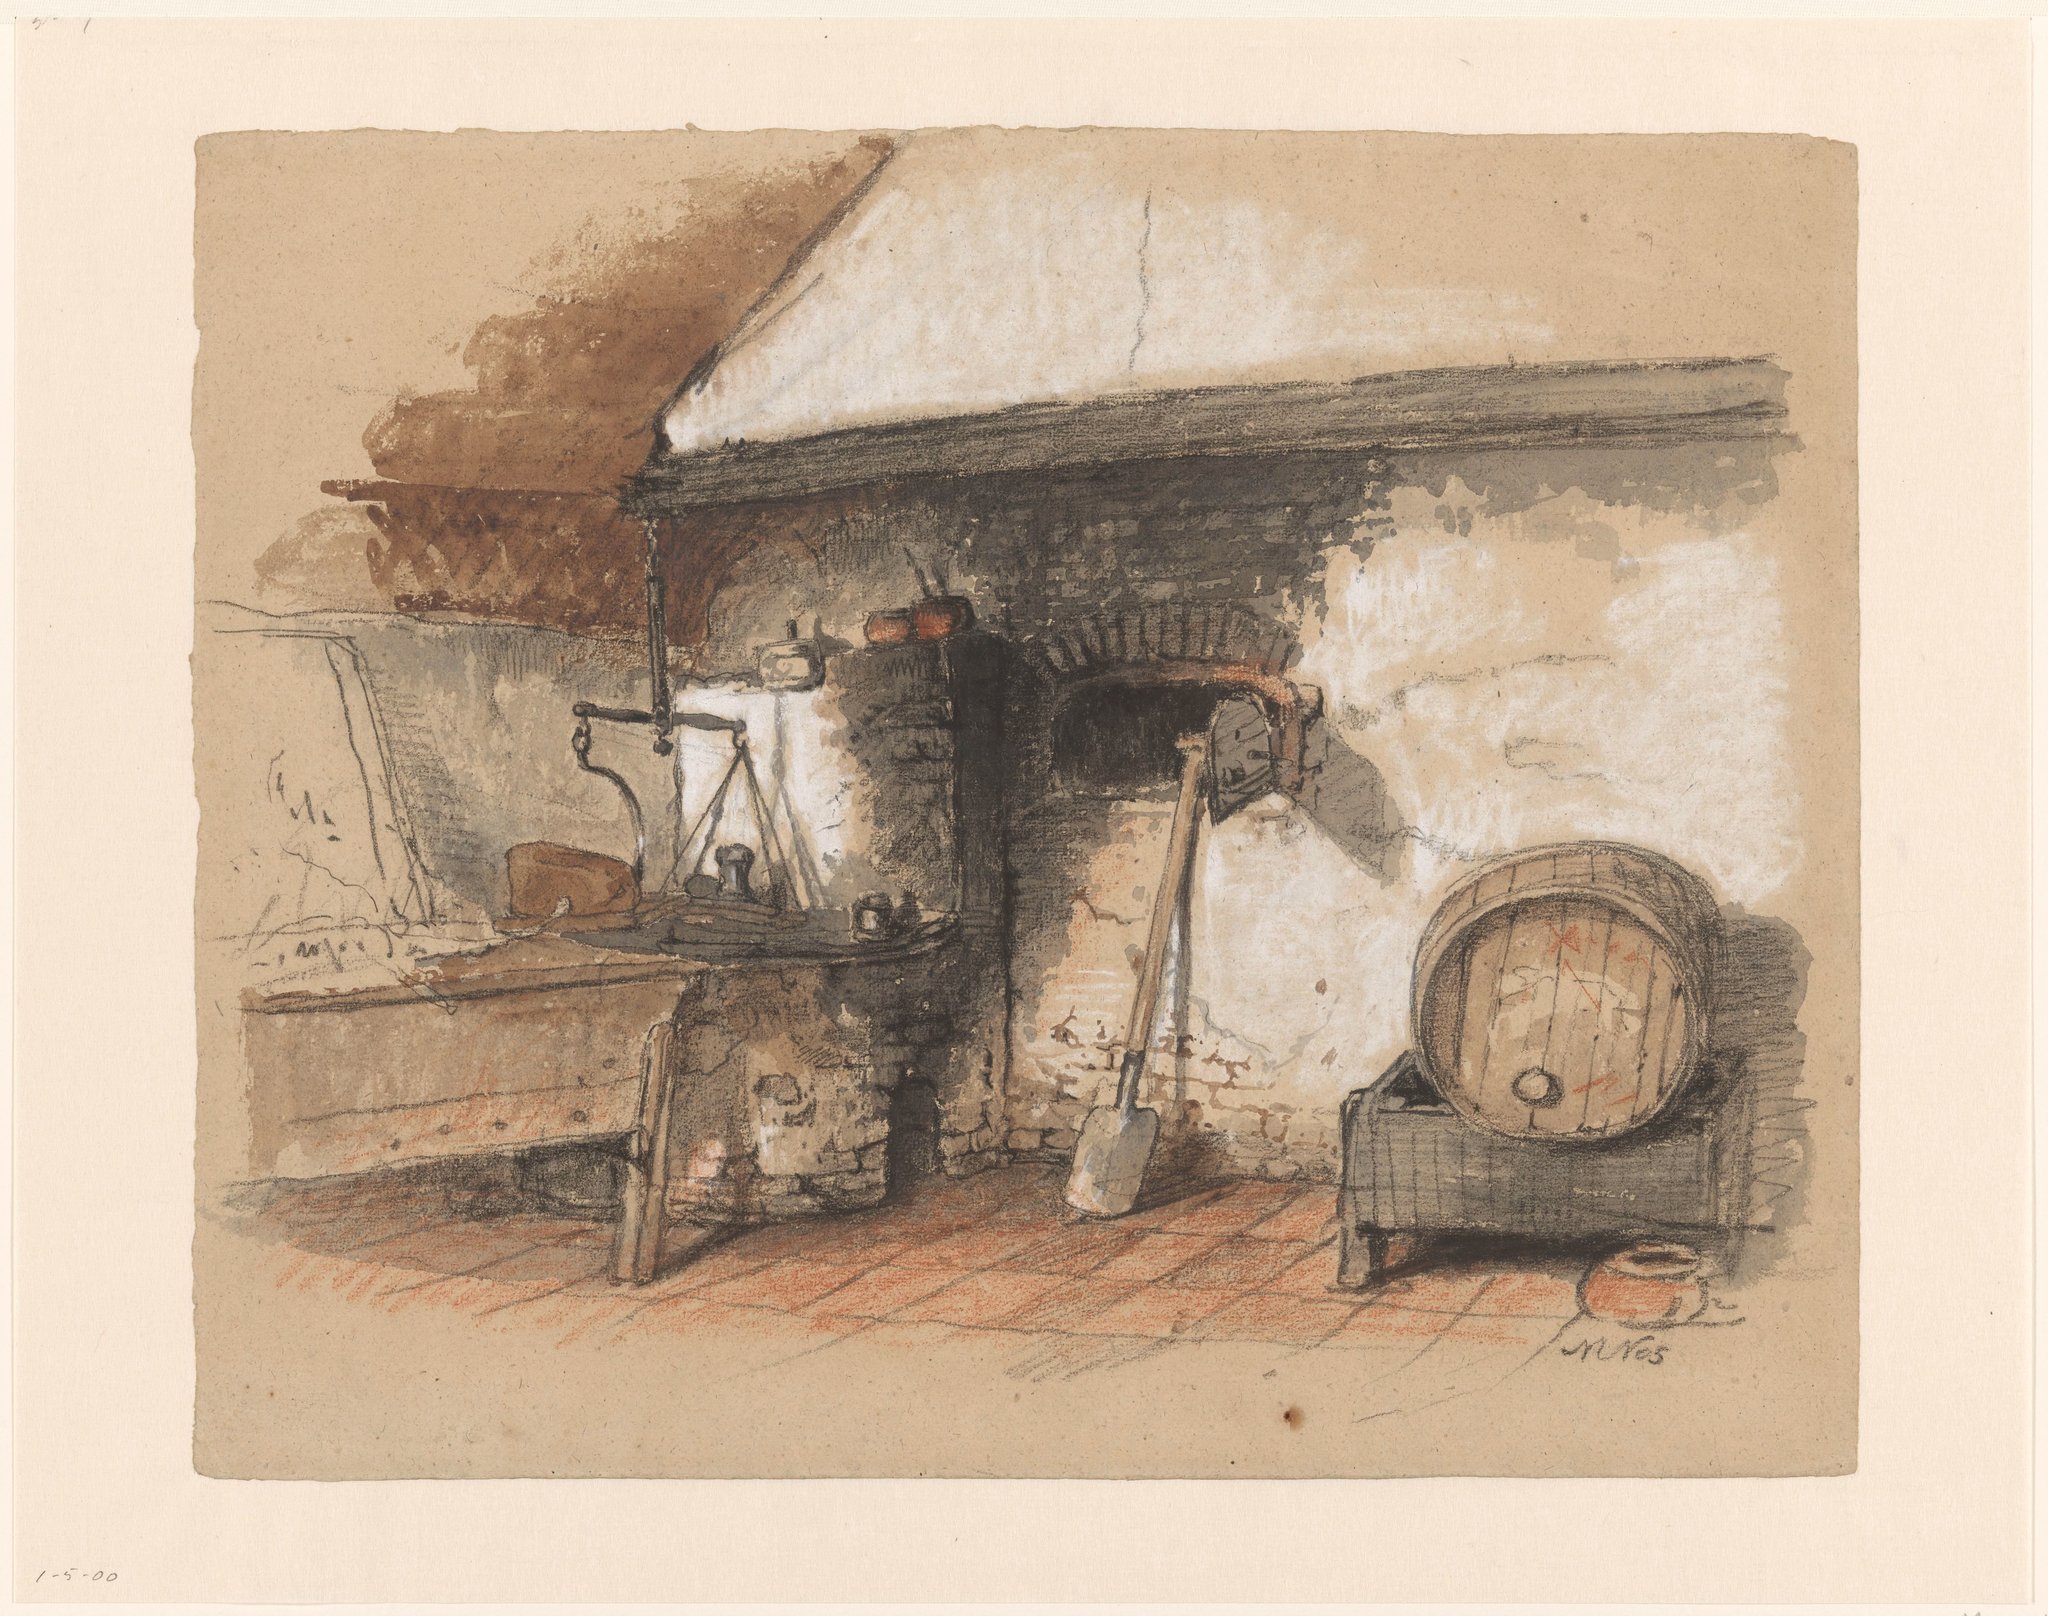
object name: drawing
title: Oude oven in een bakkerij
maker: maria vos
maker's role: draughtsman, painter, print maker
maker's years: 1824-1906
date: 1834-1906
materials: chalk, paper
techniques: brush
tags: shop, store, bread, loaf